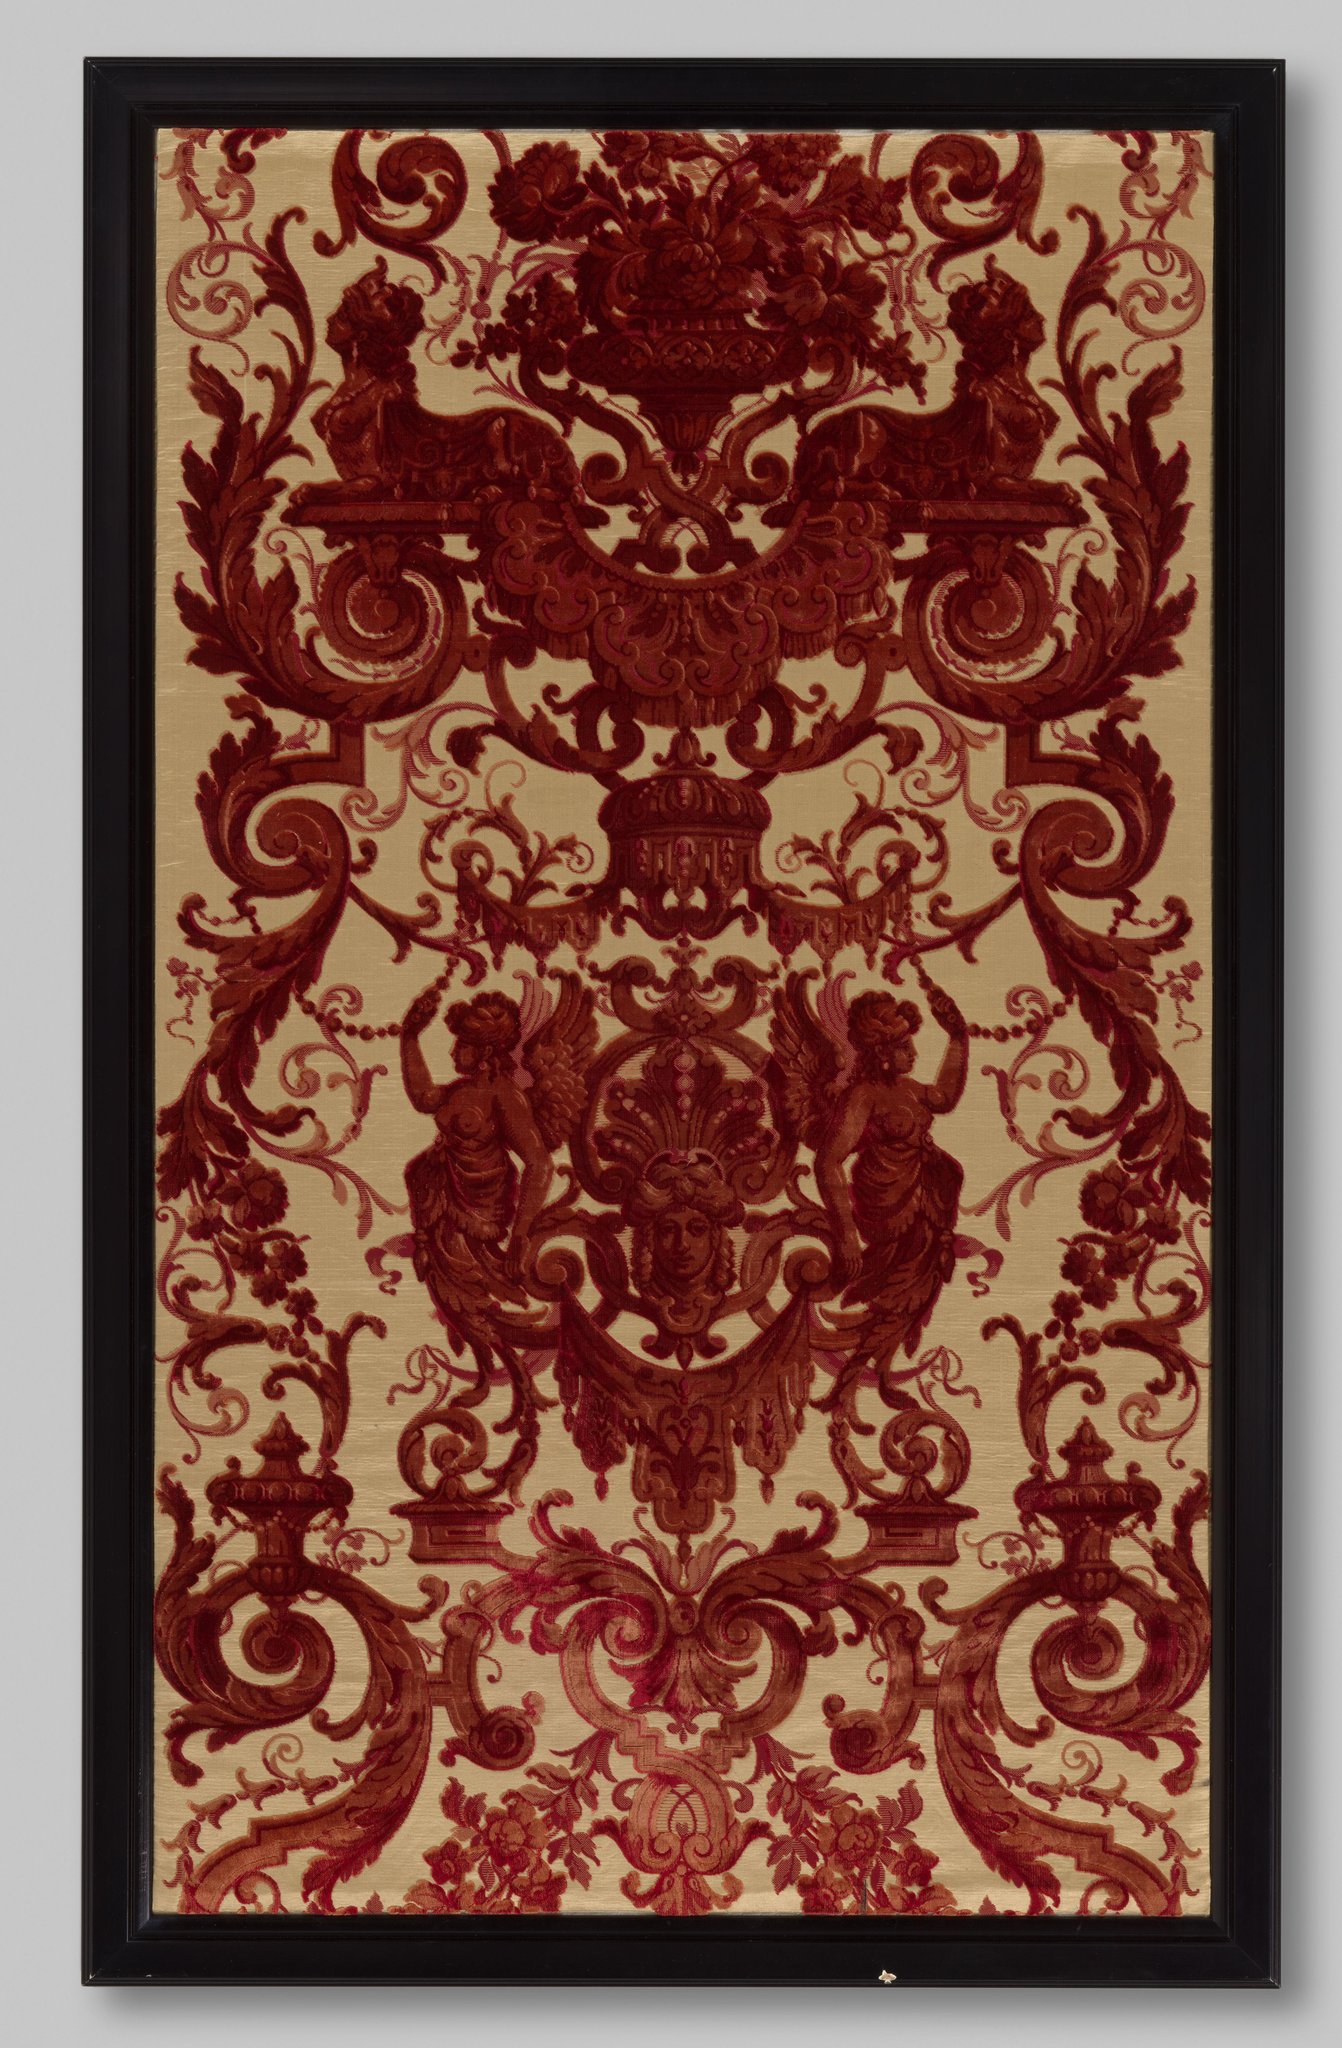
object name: fragment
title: Fragment fluweel op een satijnen grond.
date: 1865-1874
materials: textile, velvet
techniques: weave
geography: france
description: Wall covering. Cut and uncut silk velours. France, Lyon, c. 1870.